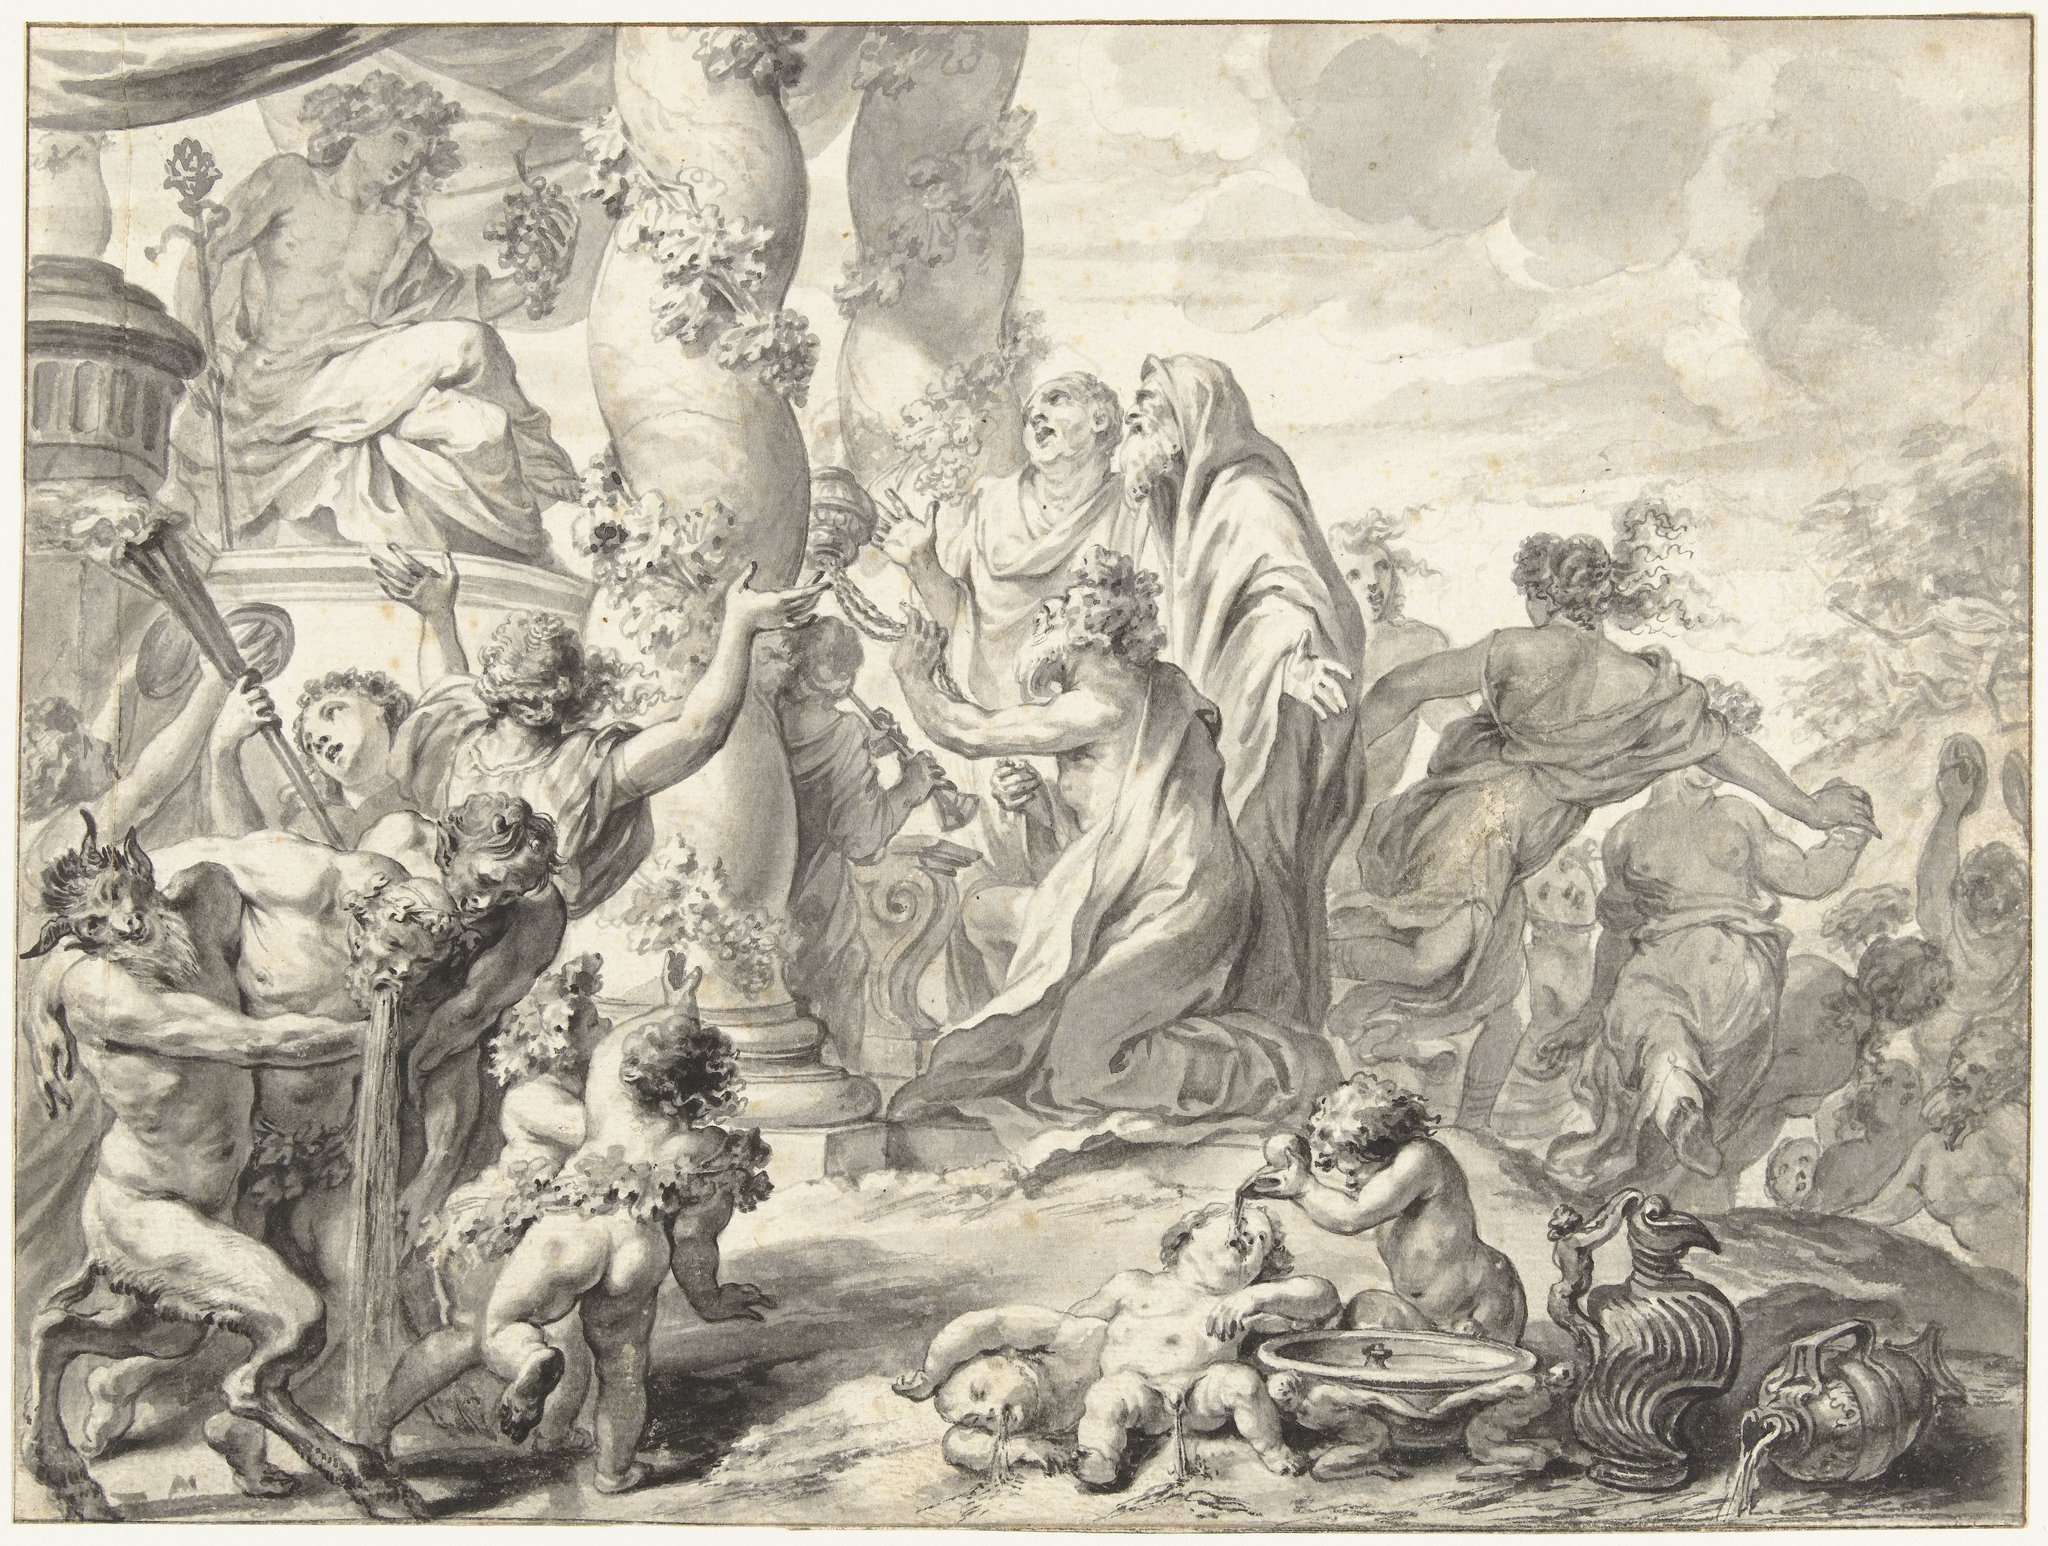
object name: drawing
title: Offer van Bacchus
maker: godfried maes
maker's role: draughtsman, painter, print maker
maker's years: 1649-1700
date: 1659-1700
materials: ink, paper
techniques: brush, pen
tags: bacchanal: bacchus with his wine-flushed train (thiasos)